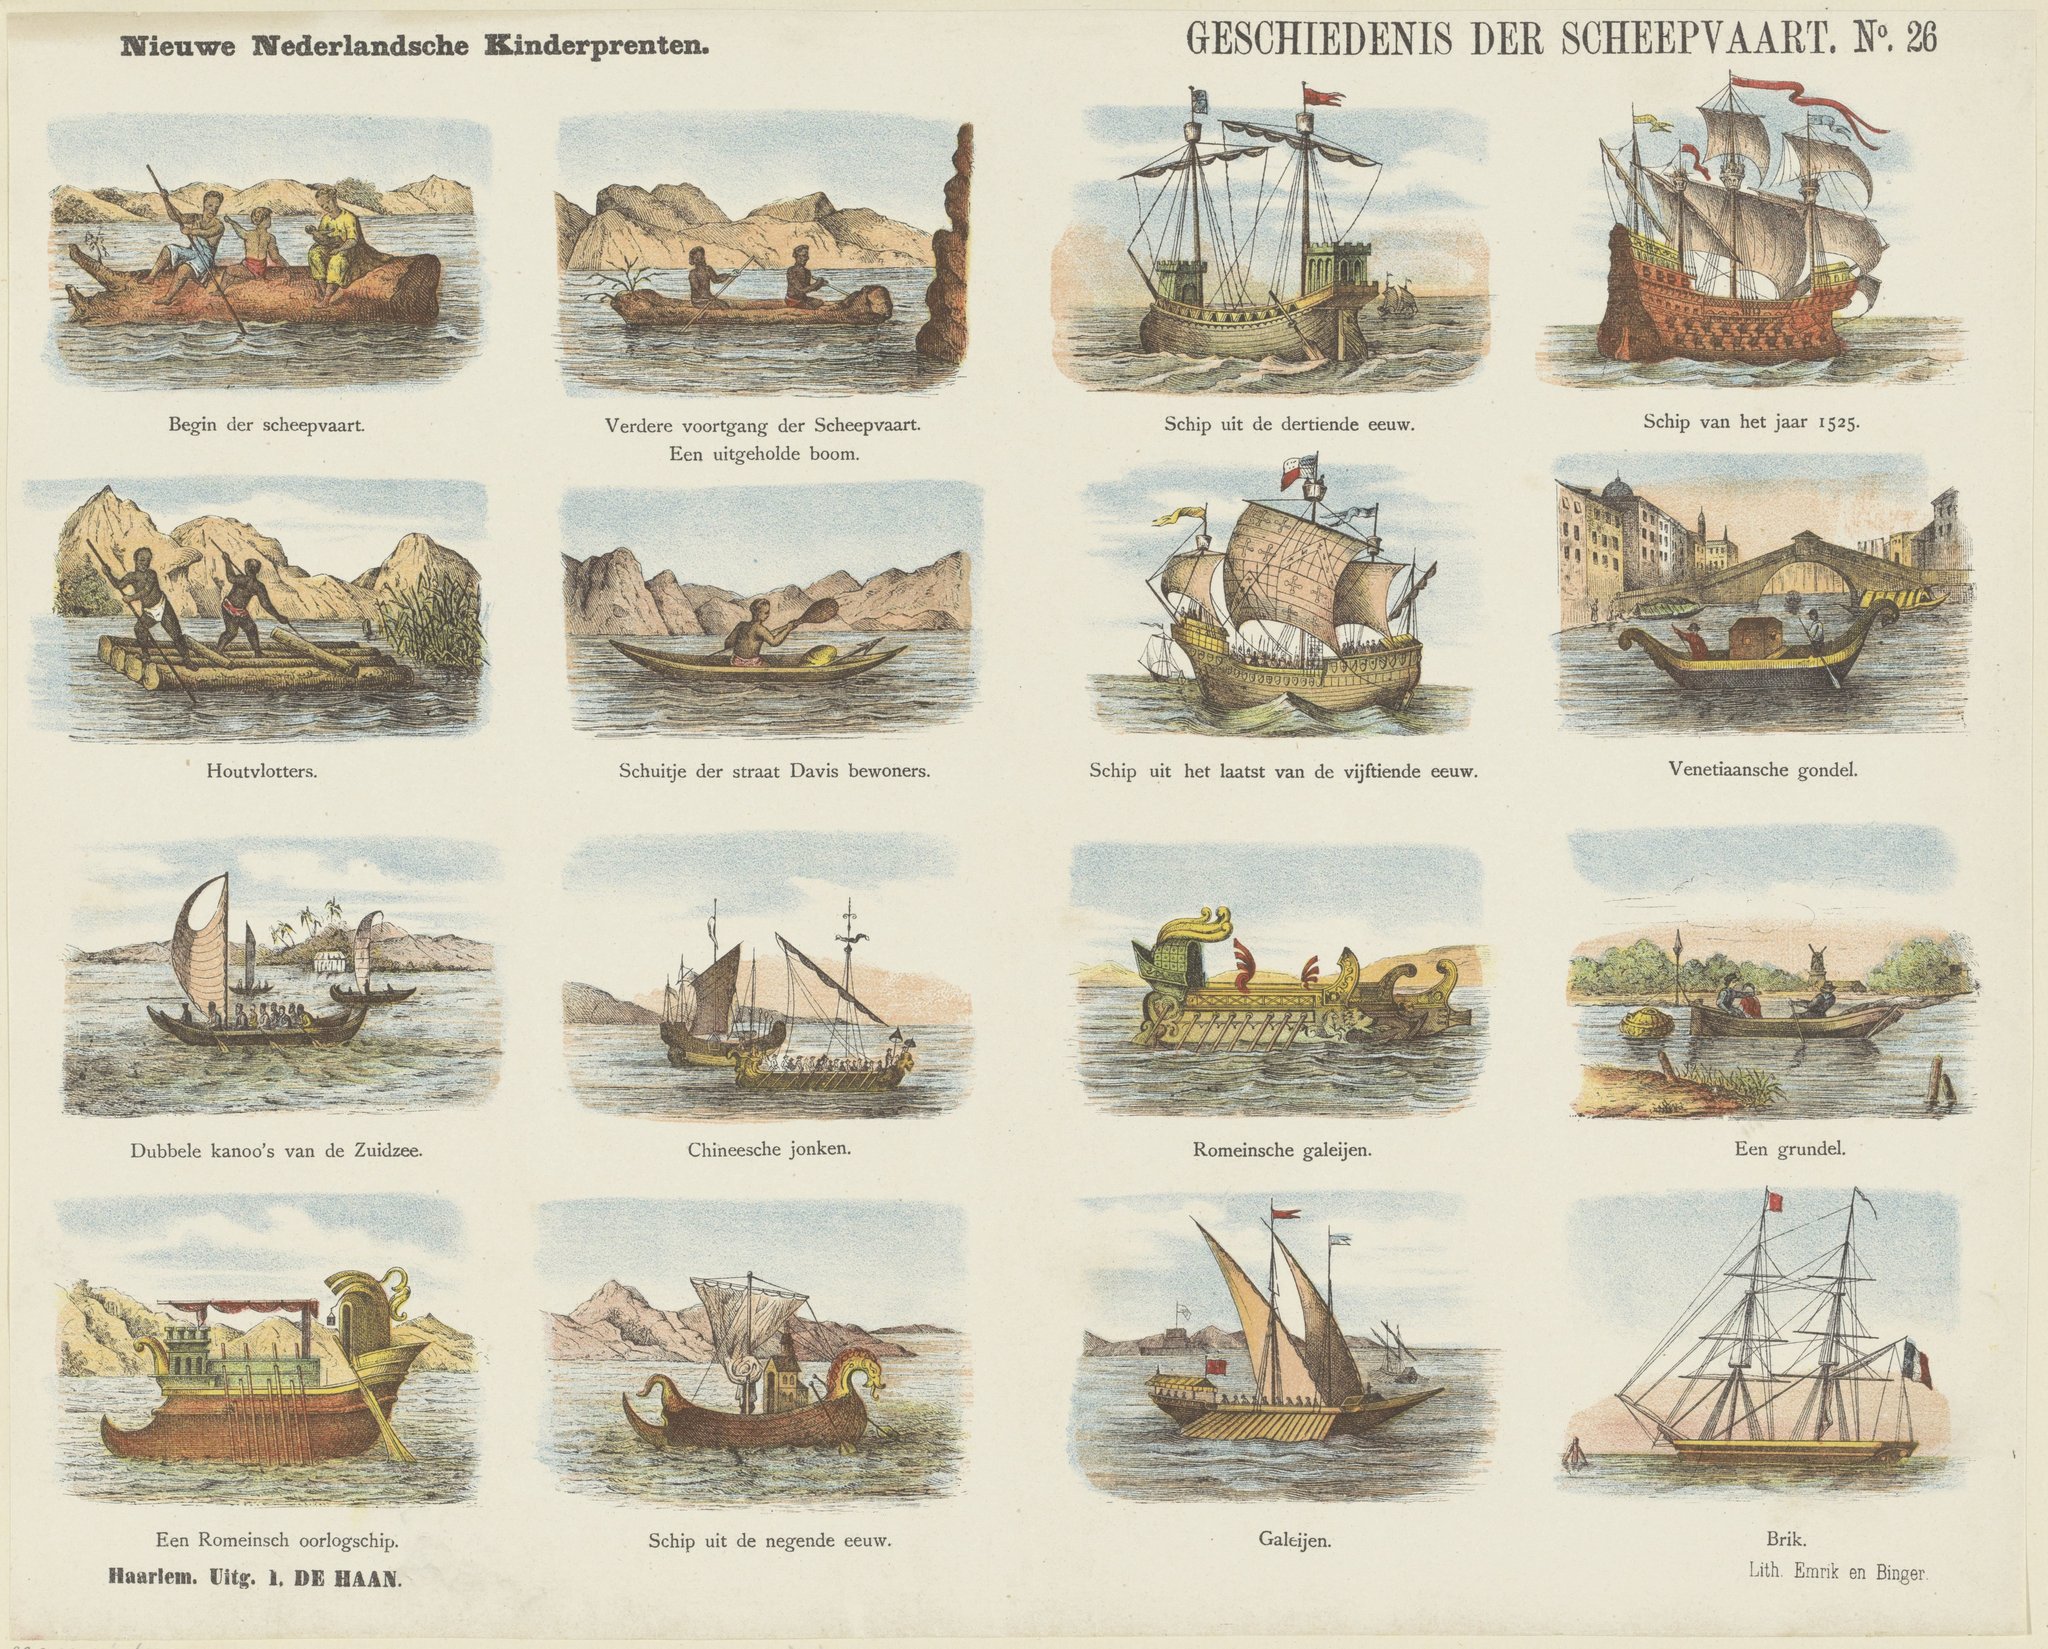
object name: popular print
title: Geschiedenis der scheepvaart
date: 1875-1903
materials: paper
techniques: lithograph, letterpress printing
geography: haarlem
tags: ships (in general)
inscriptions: collector's mark: Lugt 2760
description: Blad met 16 voorstellingen van verschillende schepen, waaronder een uitgeholde boomstam, een Romeins oorlogsschip en een brik (zeilschip). Onder elke afbeelding een onderschrift. Genummerd rechtsboven: No. 26.